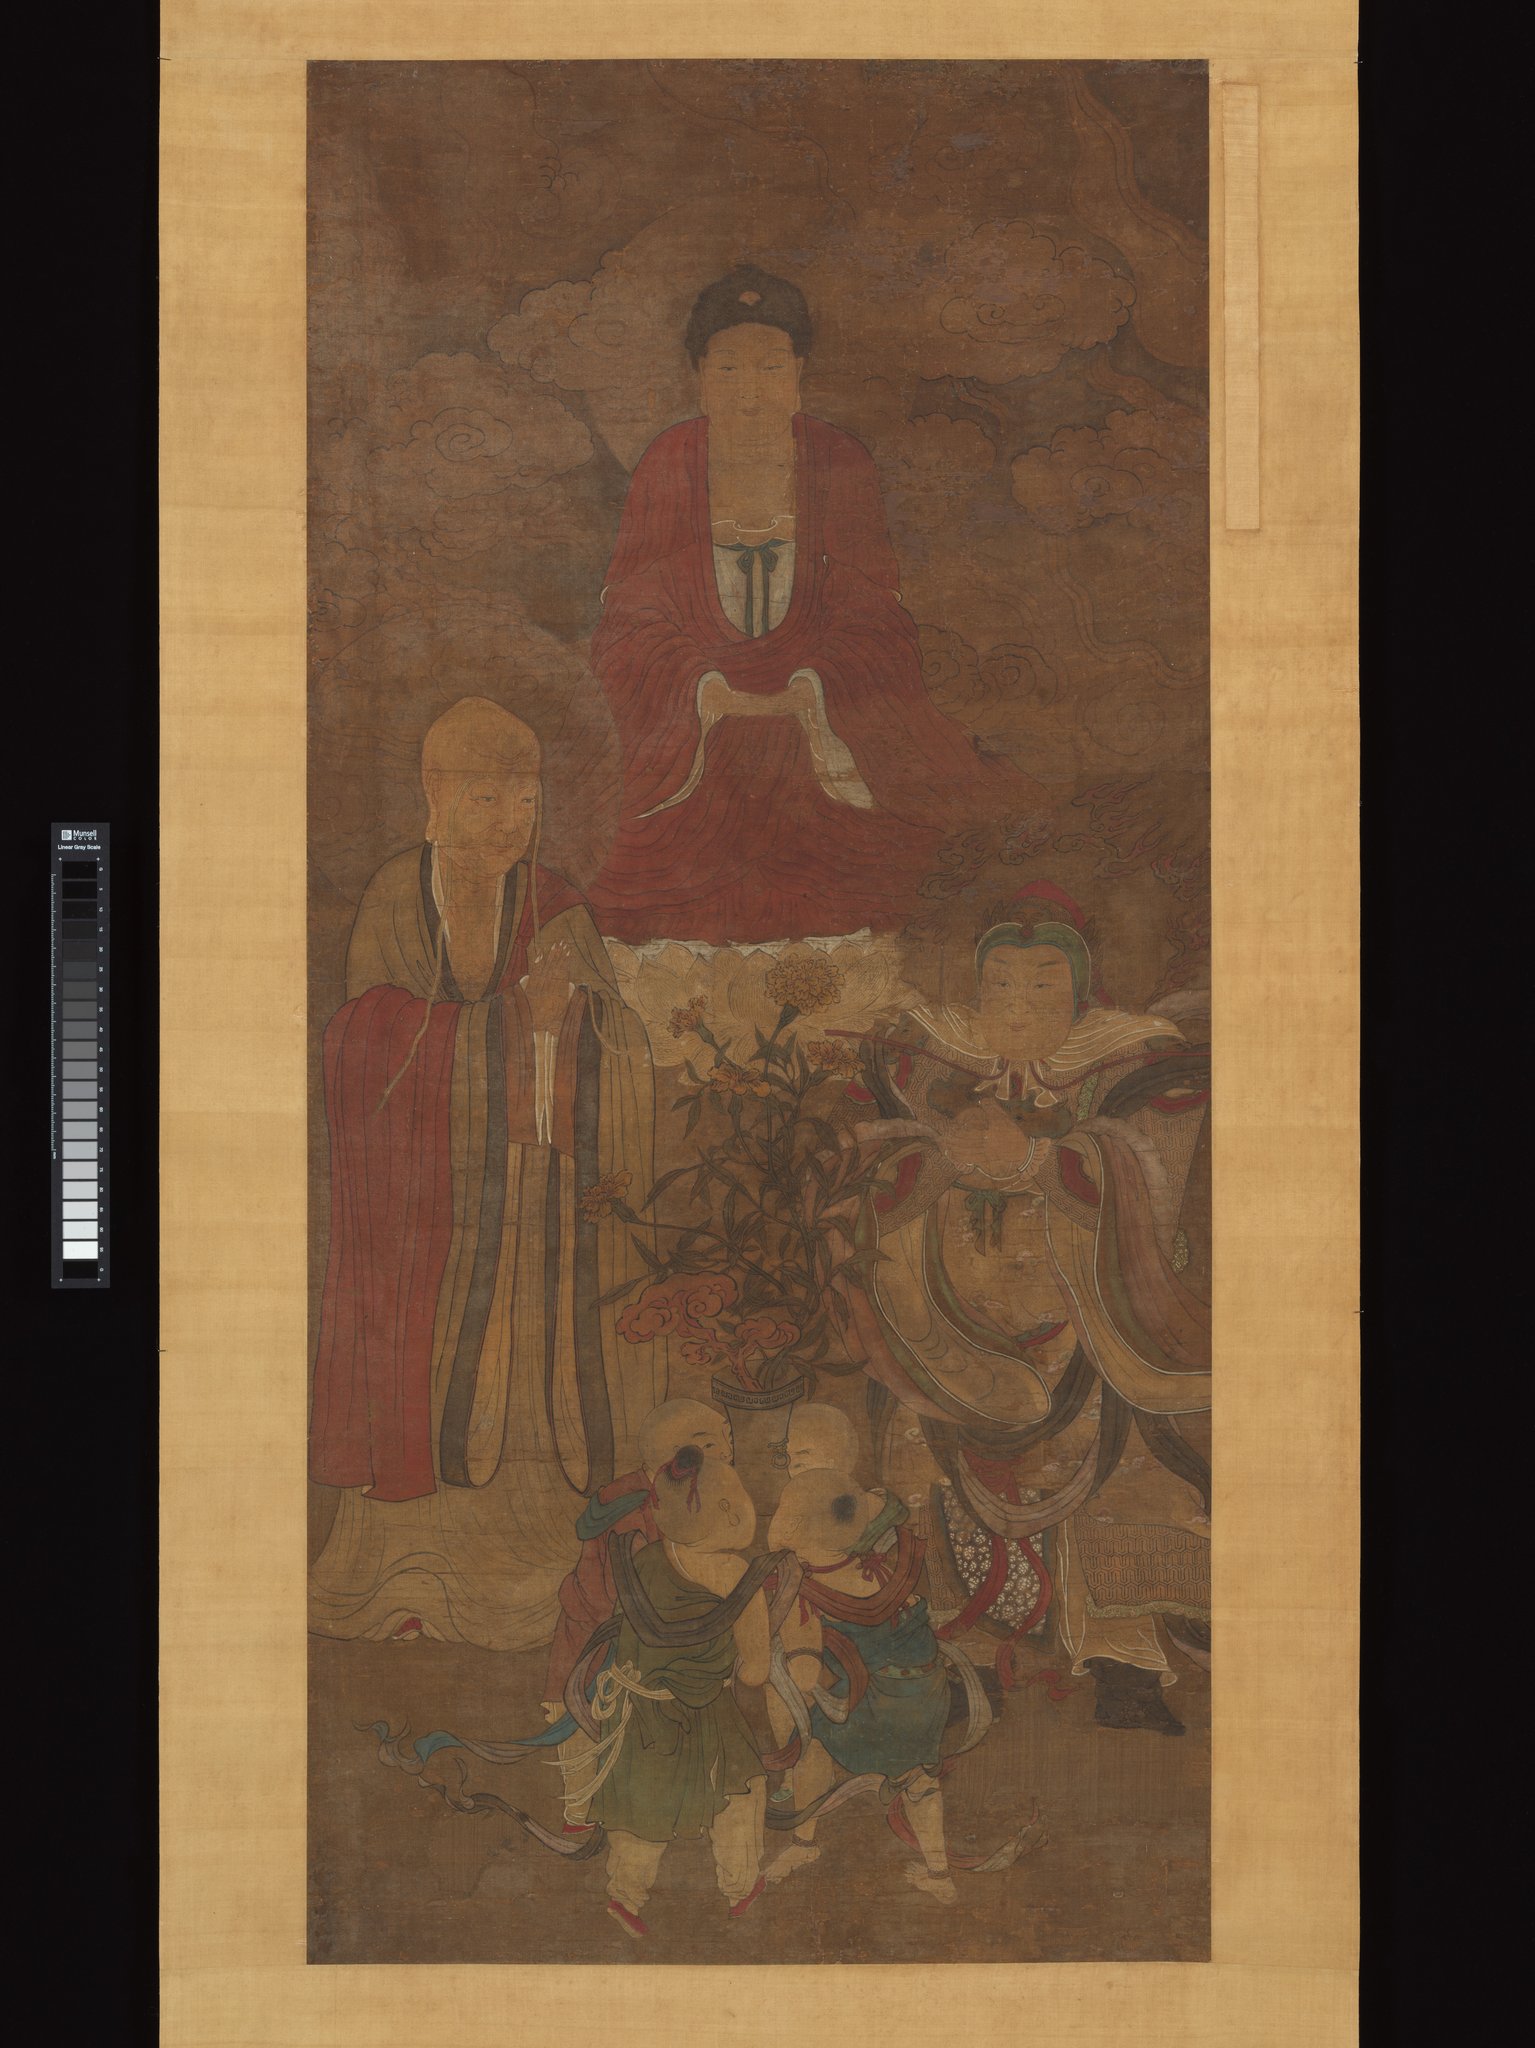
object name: hanging scroll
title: Shakyamuni with luohan, heavenly king, and boys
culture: chinese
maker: unidentified artist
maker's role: artist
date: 1601-1633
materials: ink, silk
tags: children,men,buddhism,buddha